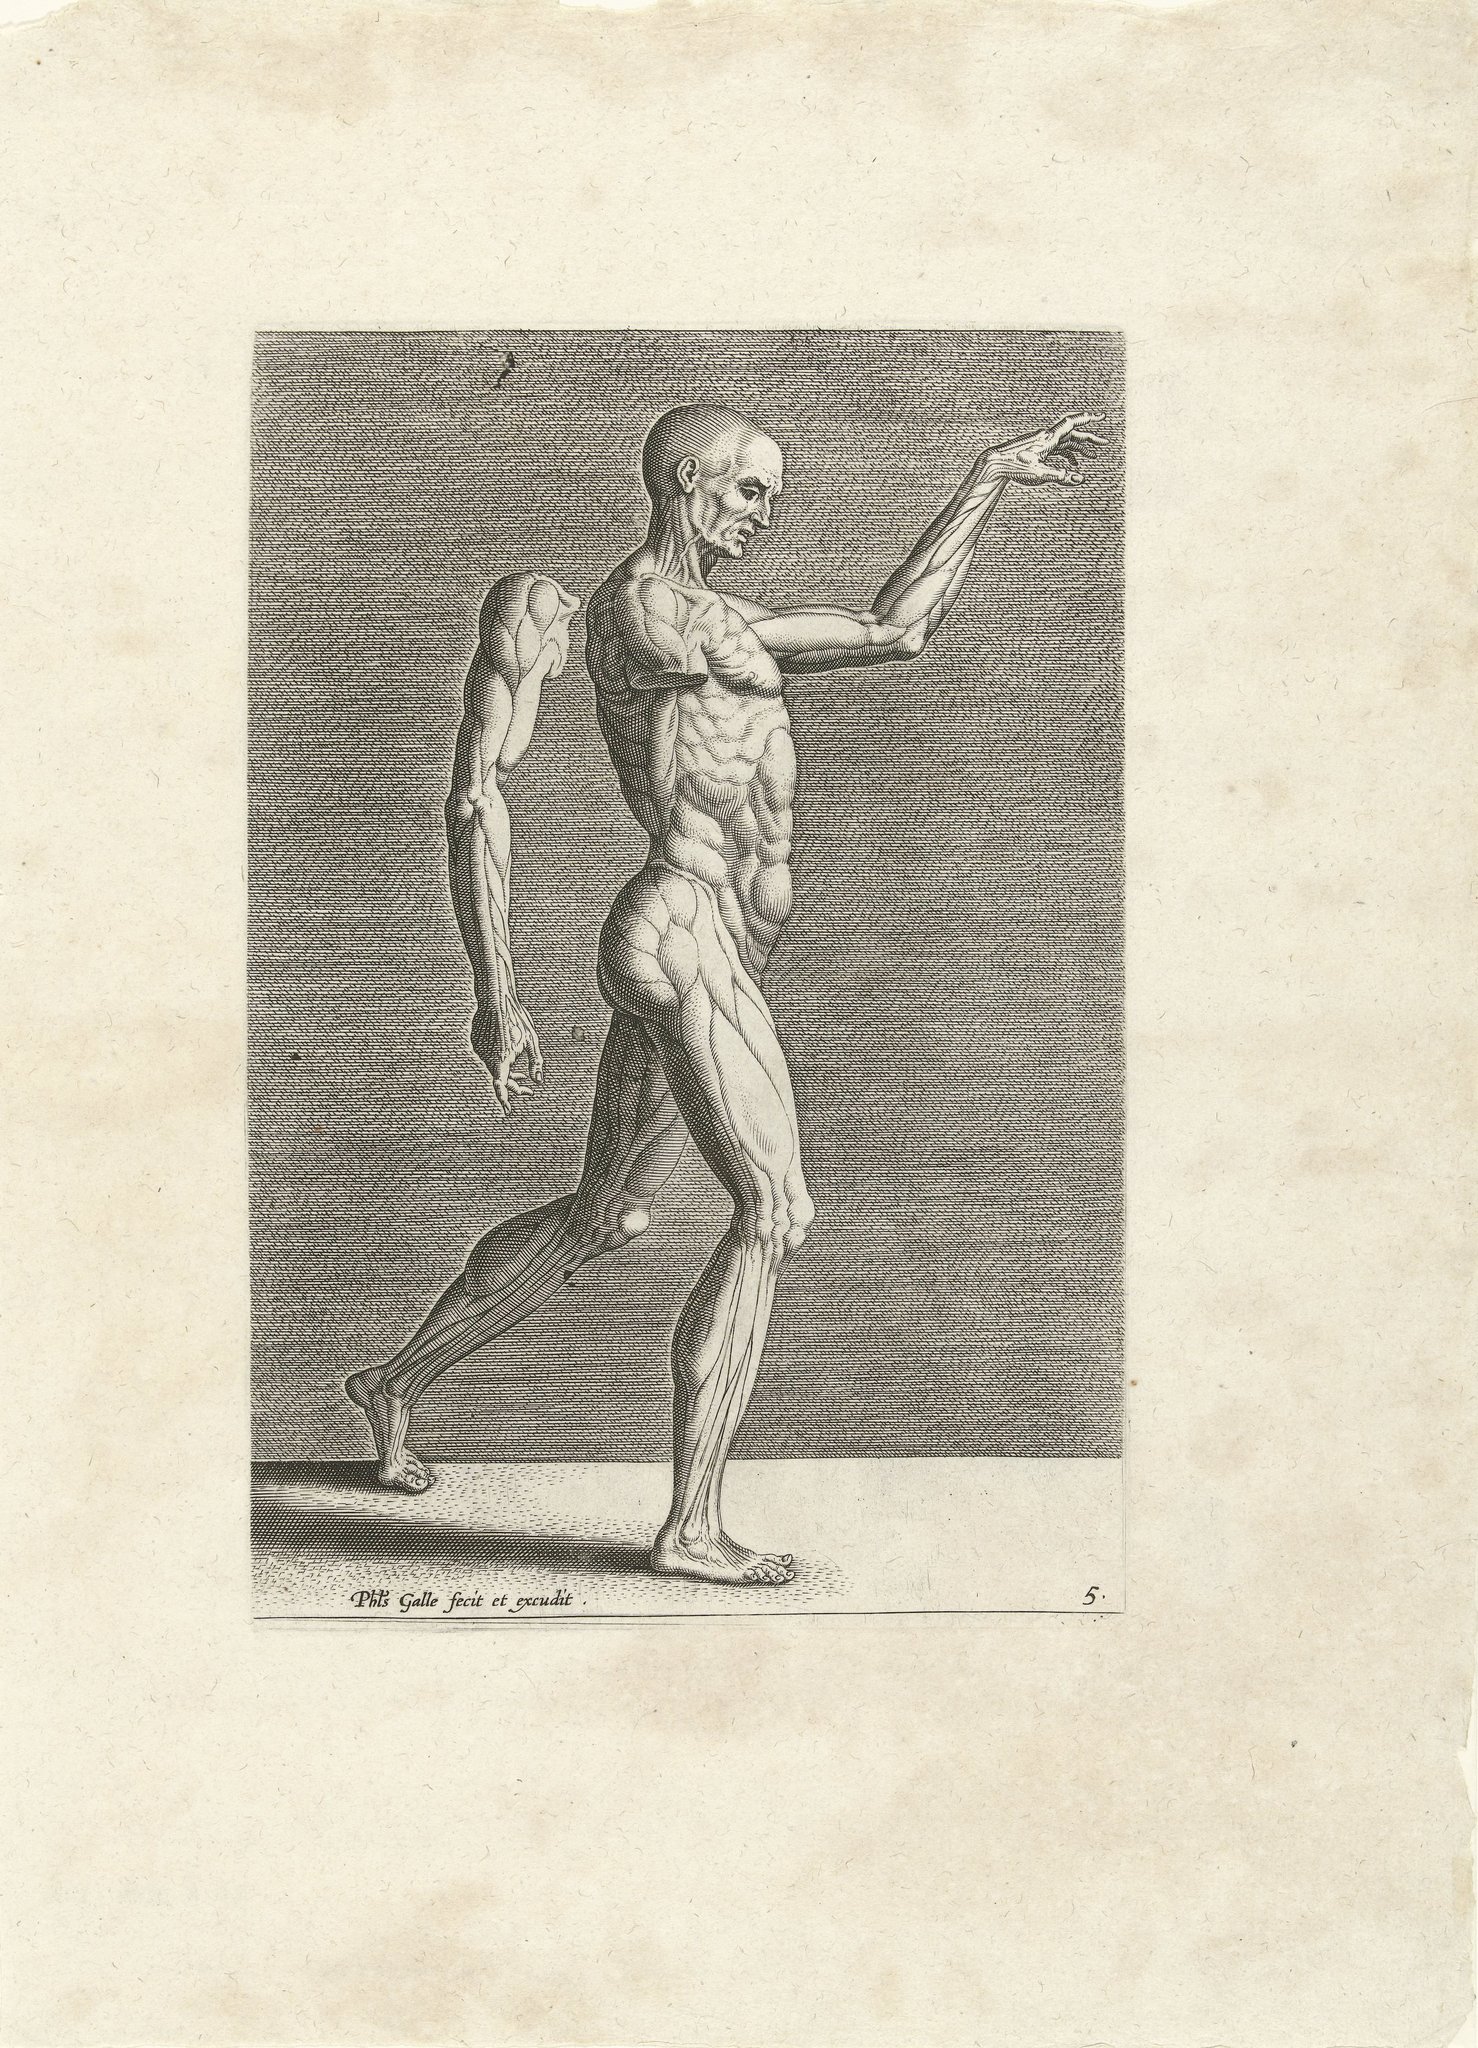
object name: print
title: Instructions et fondements de bien pourtraire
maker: philips galle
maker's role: print maker, publisher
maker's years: 1537-1612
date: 1589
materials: paper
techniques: engraving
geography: antwerp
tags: anatomical model of the muscles, muscle-man, 'écorché'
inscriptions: collector's mark: Lugt 2228, collector's mark: Lugt 2760, watermark: ‘Hand’ Briquet II 137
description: Ecorché, in profiel naar rechts. De linkerarm is los van het lichaam. De prent maakt deel uit van een dertiendelige serie over de fundamenten van het tekenen.